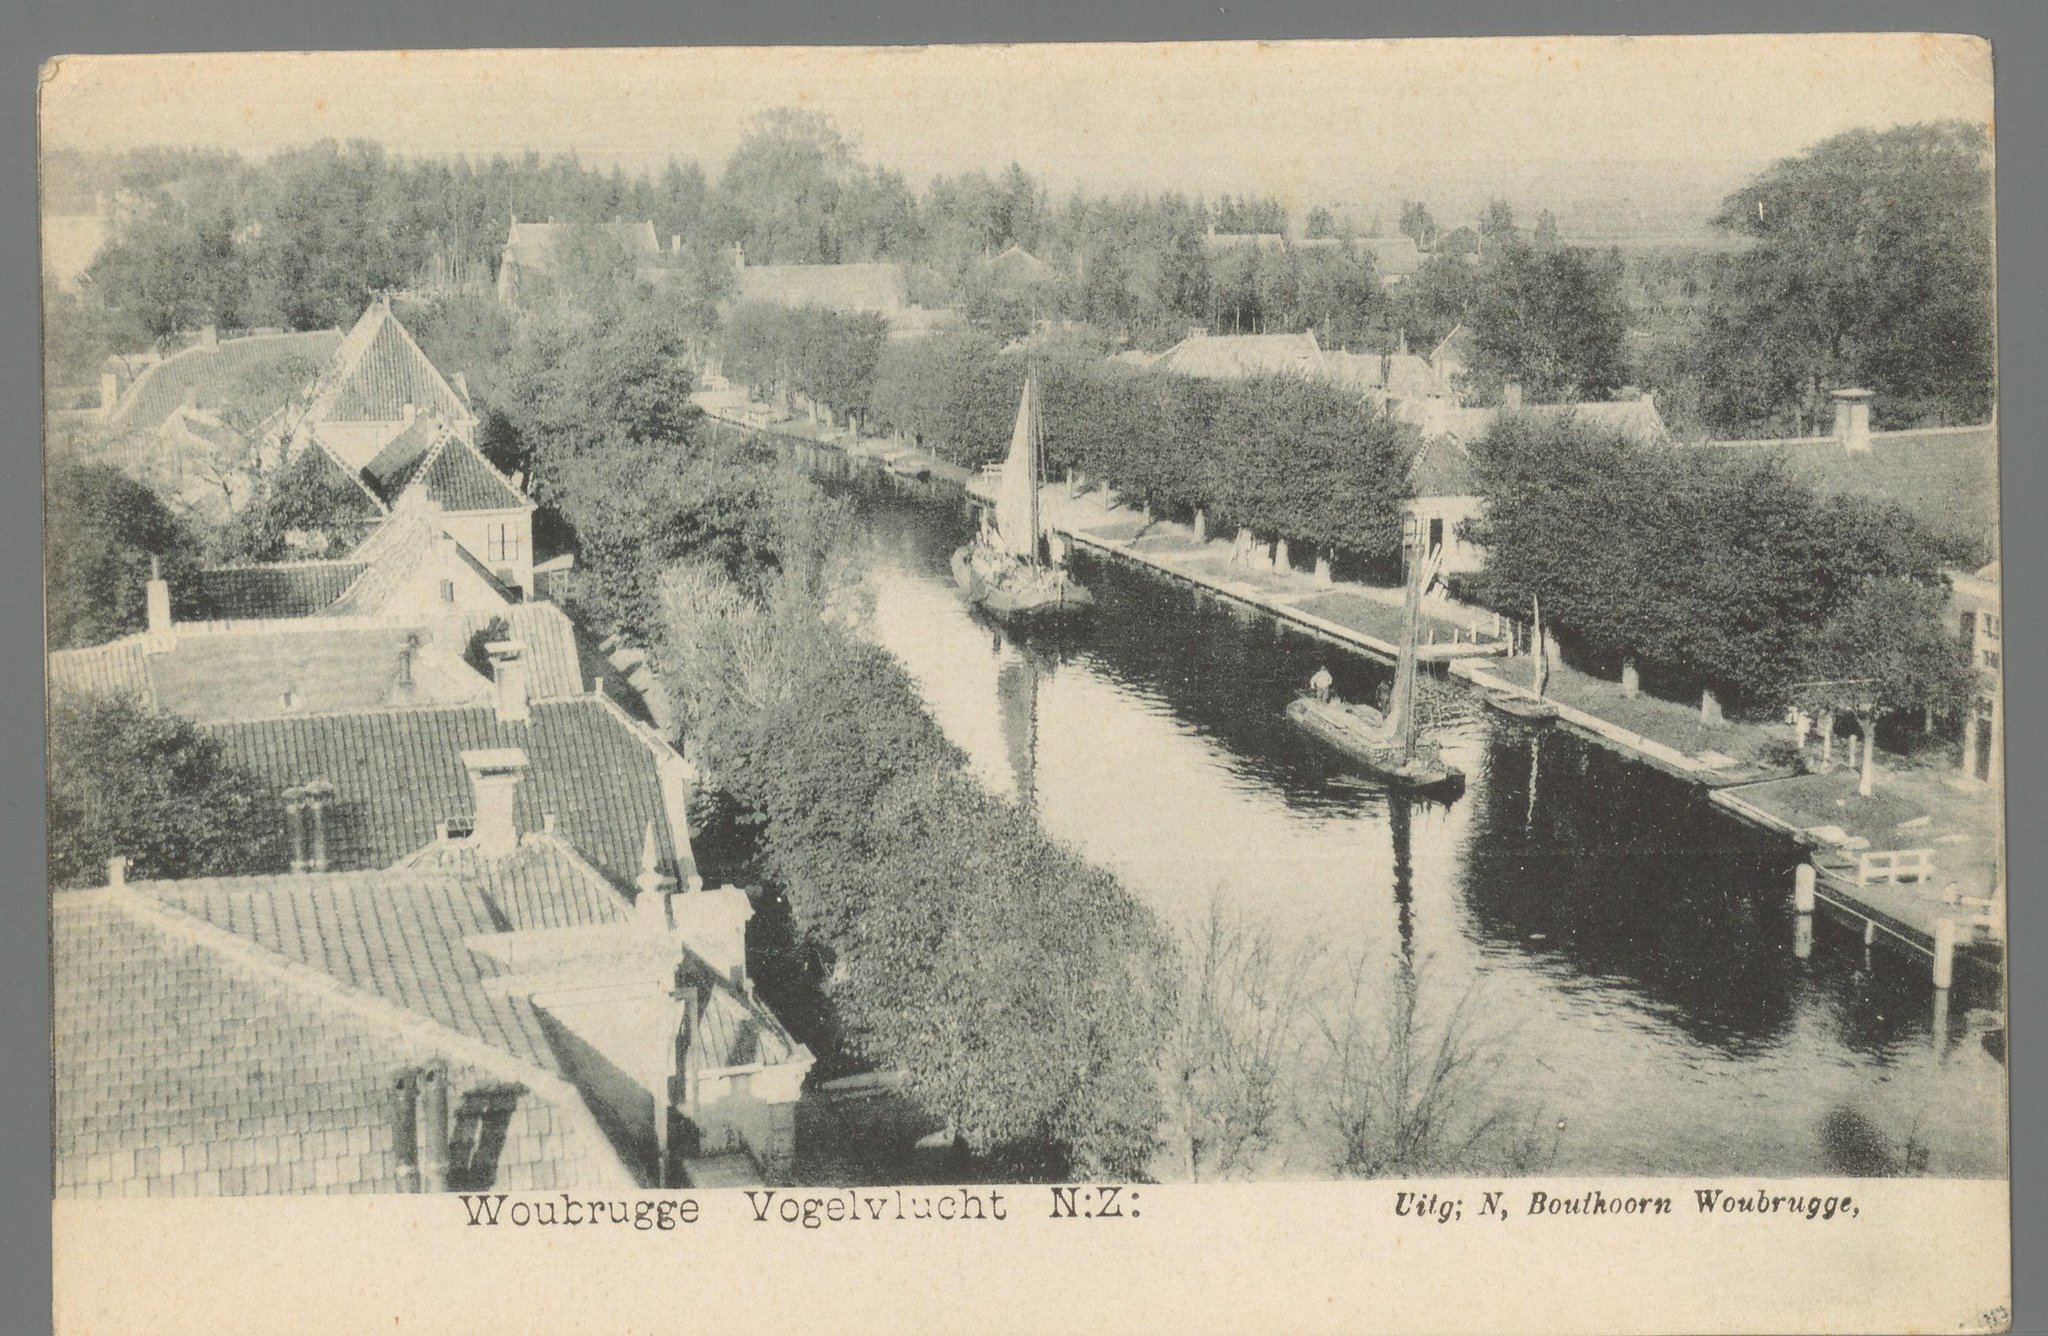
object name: ansichtkaart, prentbriefkaart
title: Woubrugge. Vogelvlucht N:Z:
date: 1897-1905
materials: cardboard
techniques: photograph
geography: woubrugge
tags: sailing-ship, sailing-boat, canals, waters (in village), prospect of city, town panorama, silhouette of city